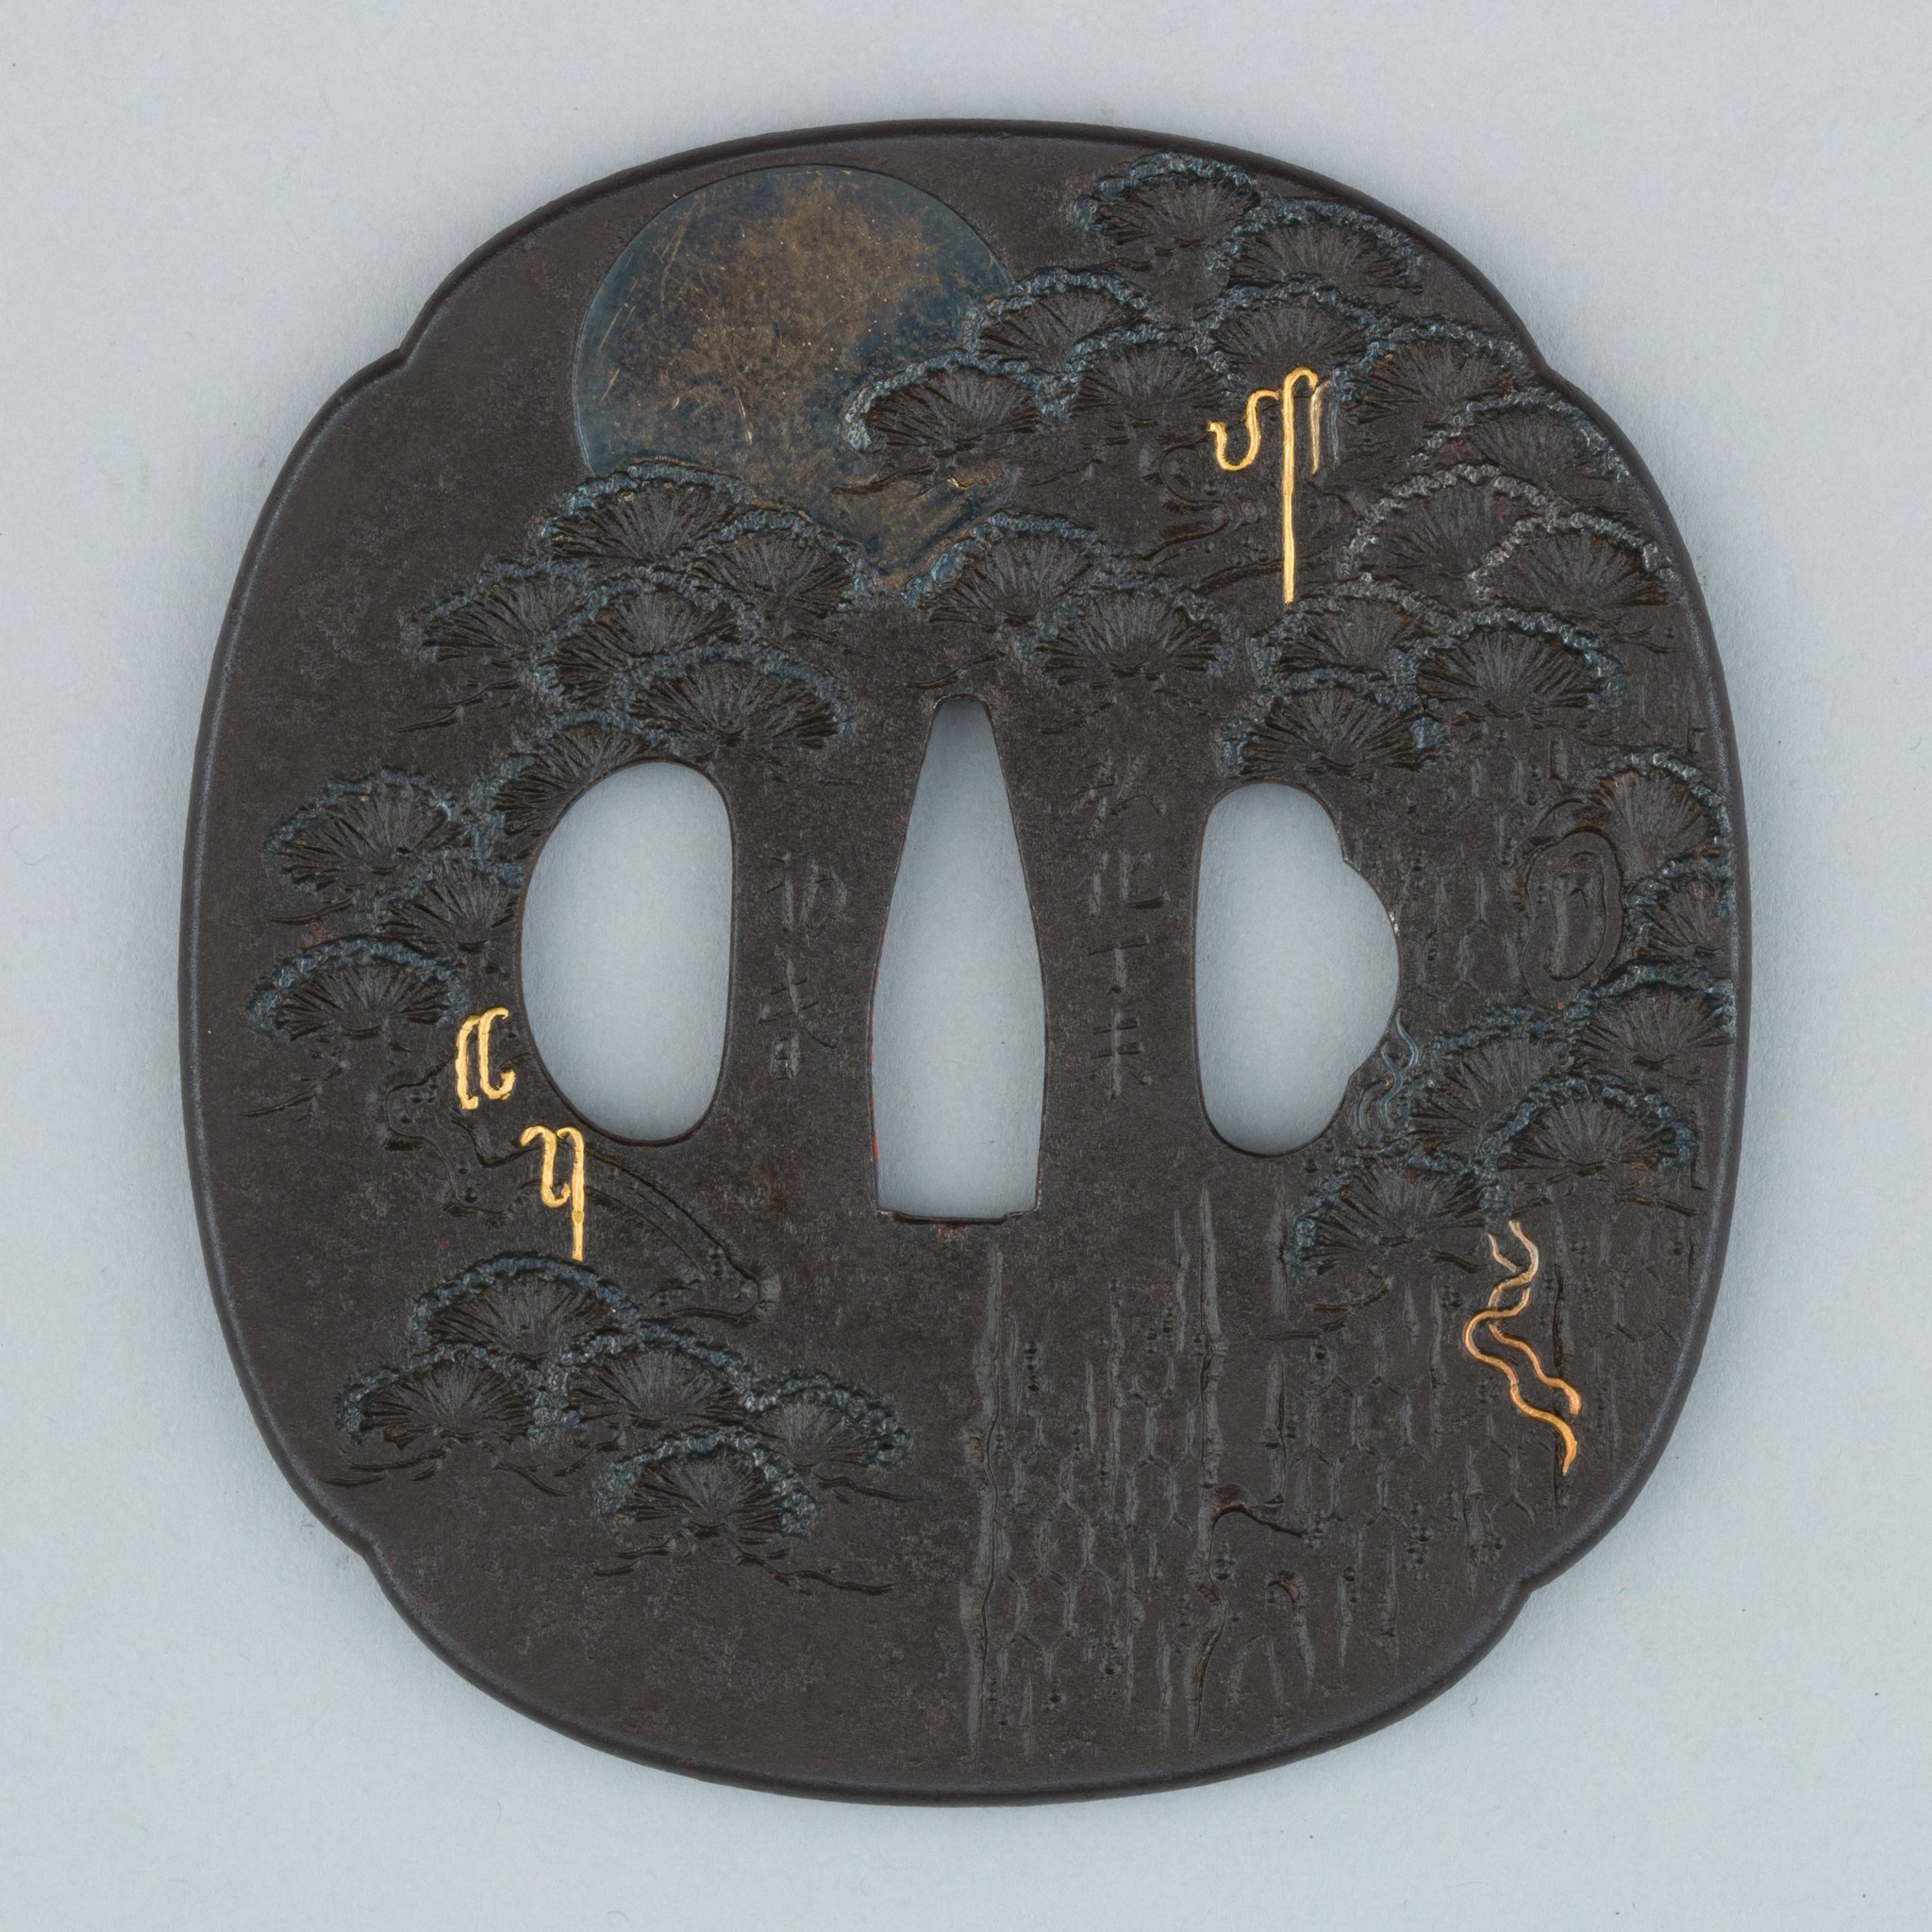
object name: sword guard tsuba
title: Sword Guard (Tsuba)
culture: japanese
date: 1844-1847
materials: copper, gold, iron, silver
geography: japan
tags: trees